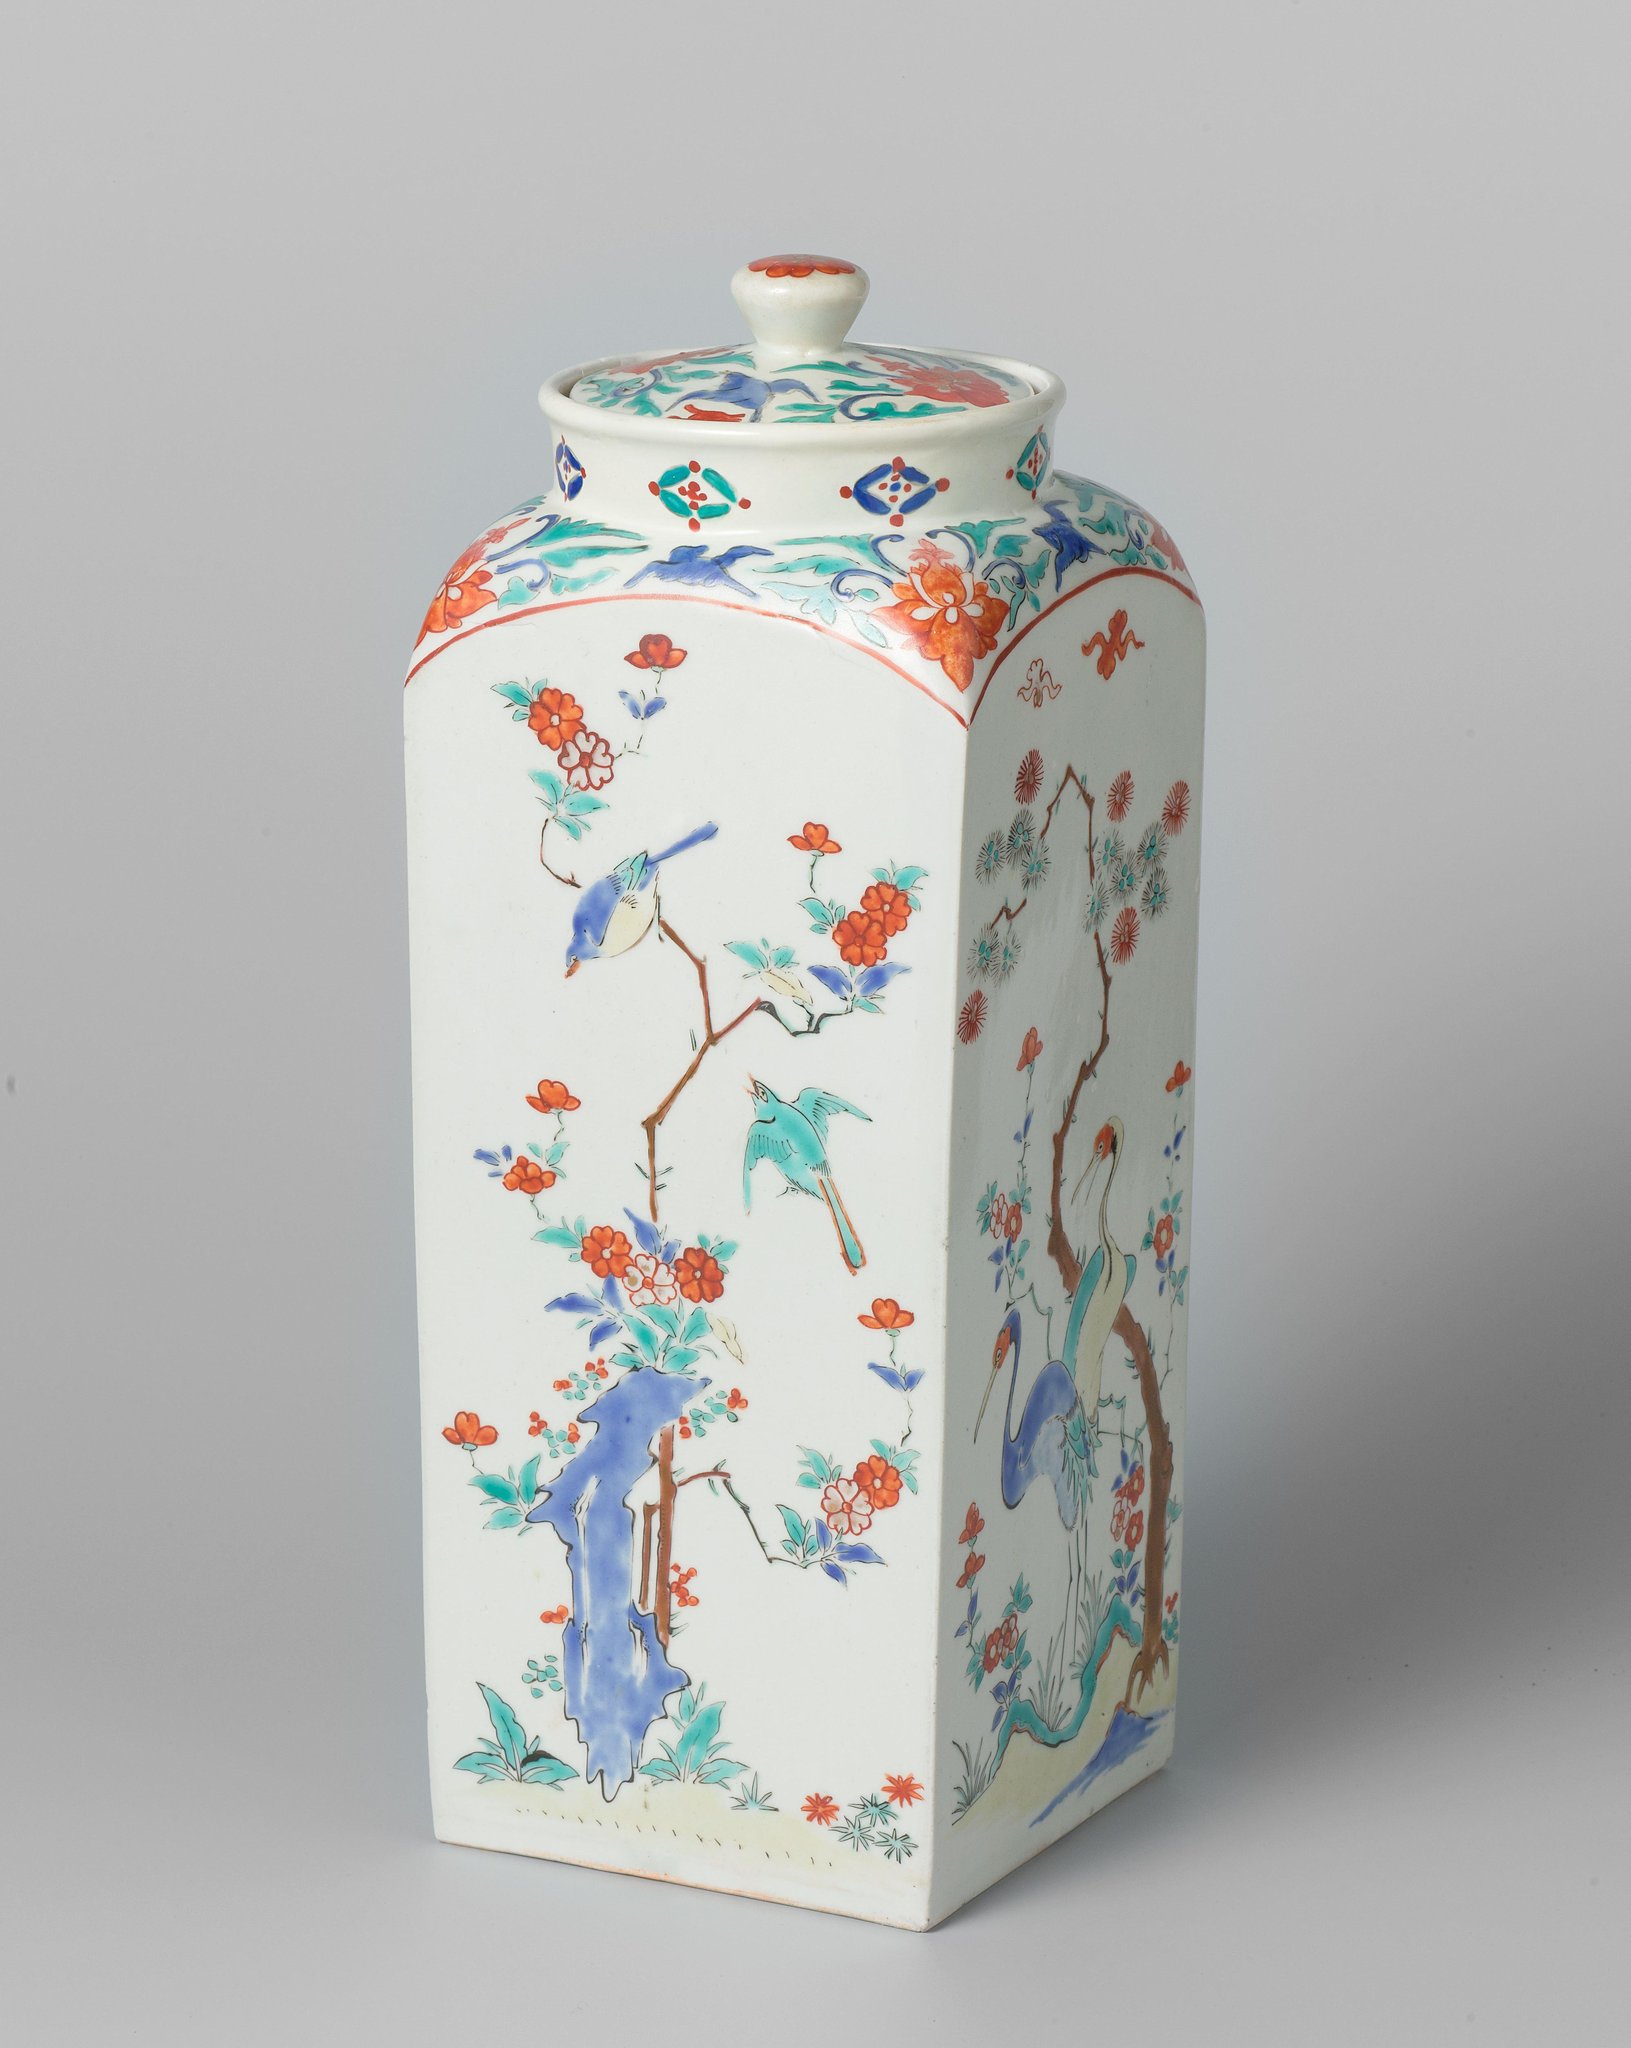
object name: bottle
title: Fles, vierkant met afgeronde schouder, ronde lage hals en rond deksel, beschilderd met onder andere ooievaars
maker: Anonymous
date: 1670-1690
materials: porcelain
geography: arita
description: Fles van porselein, vierkant met afgeronde schouder, ronde lage hals en rond deksel met knop. Beschilderd in blauw, rood, groen, geel, bruin, zwart en goud met op de wanden respectievelijk twee ooievaars op rotsachtige bodem bij pijnboom en prunus, twee vogels op de tak van een prunus bij rotsen, twee vogels op bamboe bij rotsen en twee vogels op een prunusachtige boom bij rots. Op de schouder symmetrische bloemranken en vogels. Op de hals ornamenten. Rozet in rood en goud op knop. Tussen schouder en wanden een gebogen rode bies. Kakiemon decor.